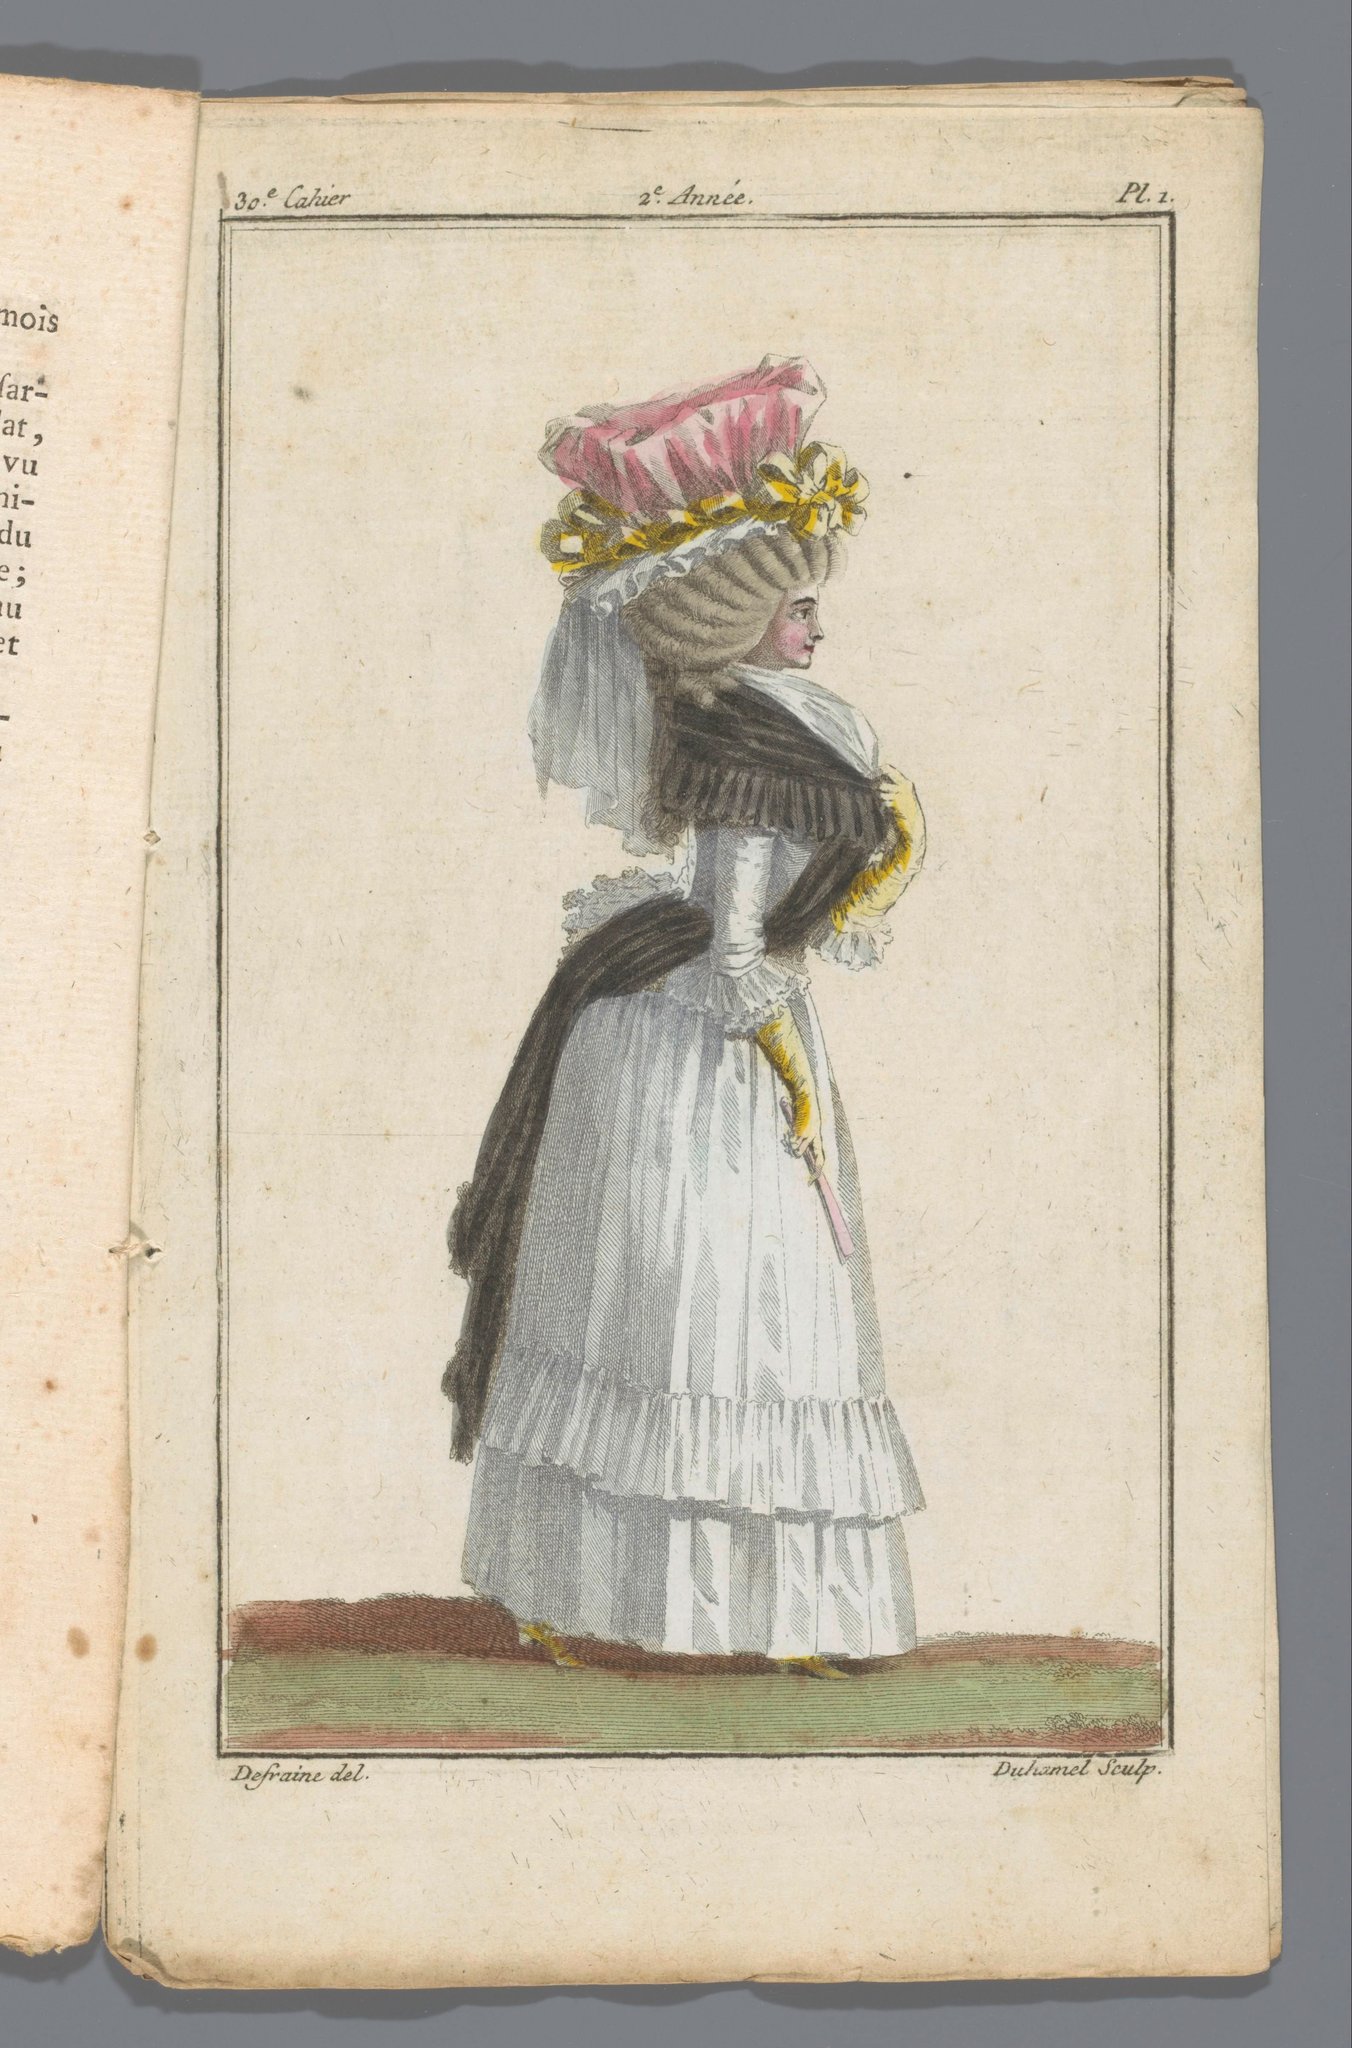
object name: fashion print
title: Magasin des Modes Nouvelles Françaises et Anglaises, 10 septembre 1787, 30e cahier, 2e année, Pl. 1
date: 1787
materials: paper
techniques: engraving, hand coloring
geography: paris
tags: clothing for the upper part of the body (caraco) (+ women's clothes), gloves, mittens (long gloves) (+ women's clothes), clothing for the upper part of the body (mantelet) (+ women's clothes), head-gear: cap (+ women's clothes), fashion plates, skirt (+ women's clothes), fan (+ women's clothes), piece of clothing covering the breast or décolleté (fichu) (+ women's clothes)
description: Vrouw, lopend naar rechts, gekleed in een caraco van mousseline op een rok met falbala. Zij draagt een fichu en een kleine schoudermantel. Accessoires: roze muts met geel lint en afhangende slip, lange handschoenen, waaier, schoenen met hakken. De prent maakt deel uit van het 30e Cahier, 2e année, uit de serie Magasin des Modes Nouvelles Françaises et Anglaises. De serie bestaat uit 172 modeprenten, uitgegeven door Buisson, Parijs, 20 novembre 1786 - 21 décembre 1789.